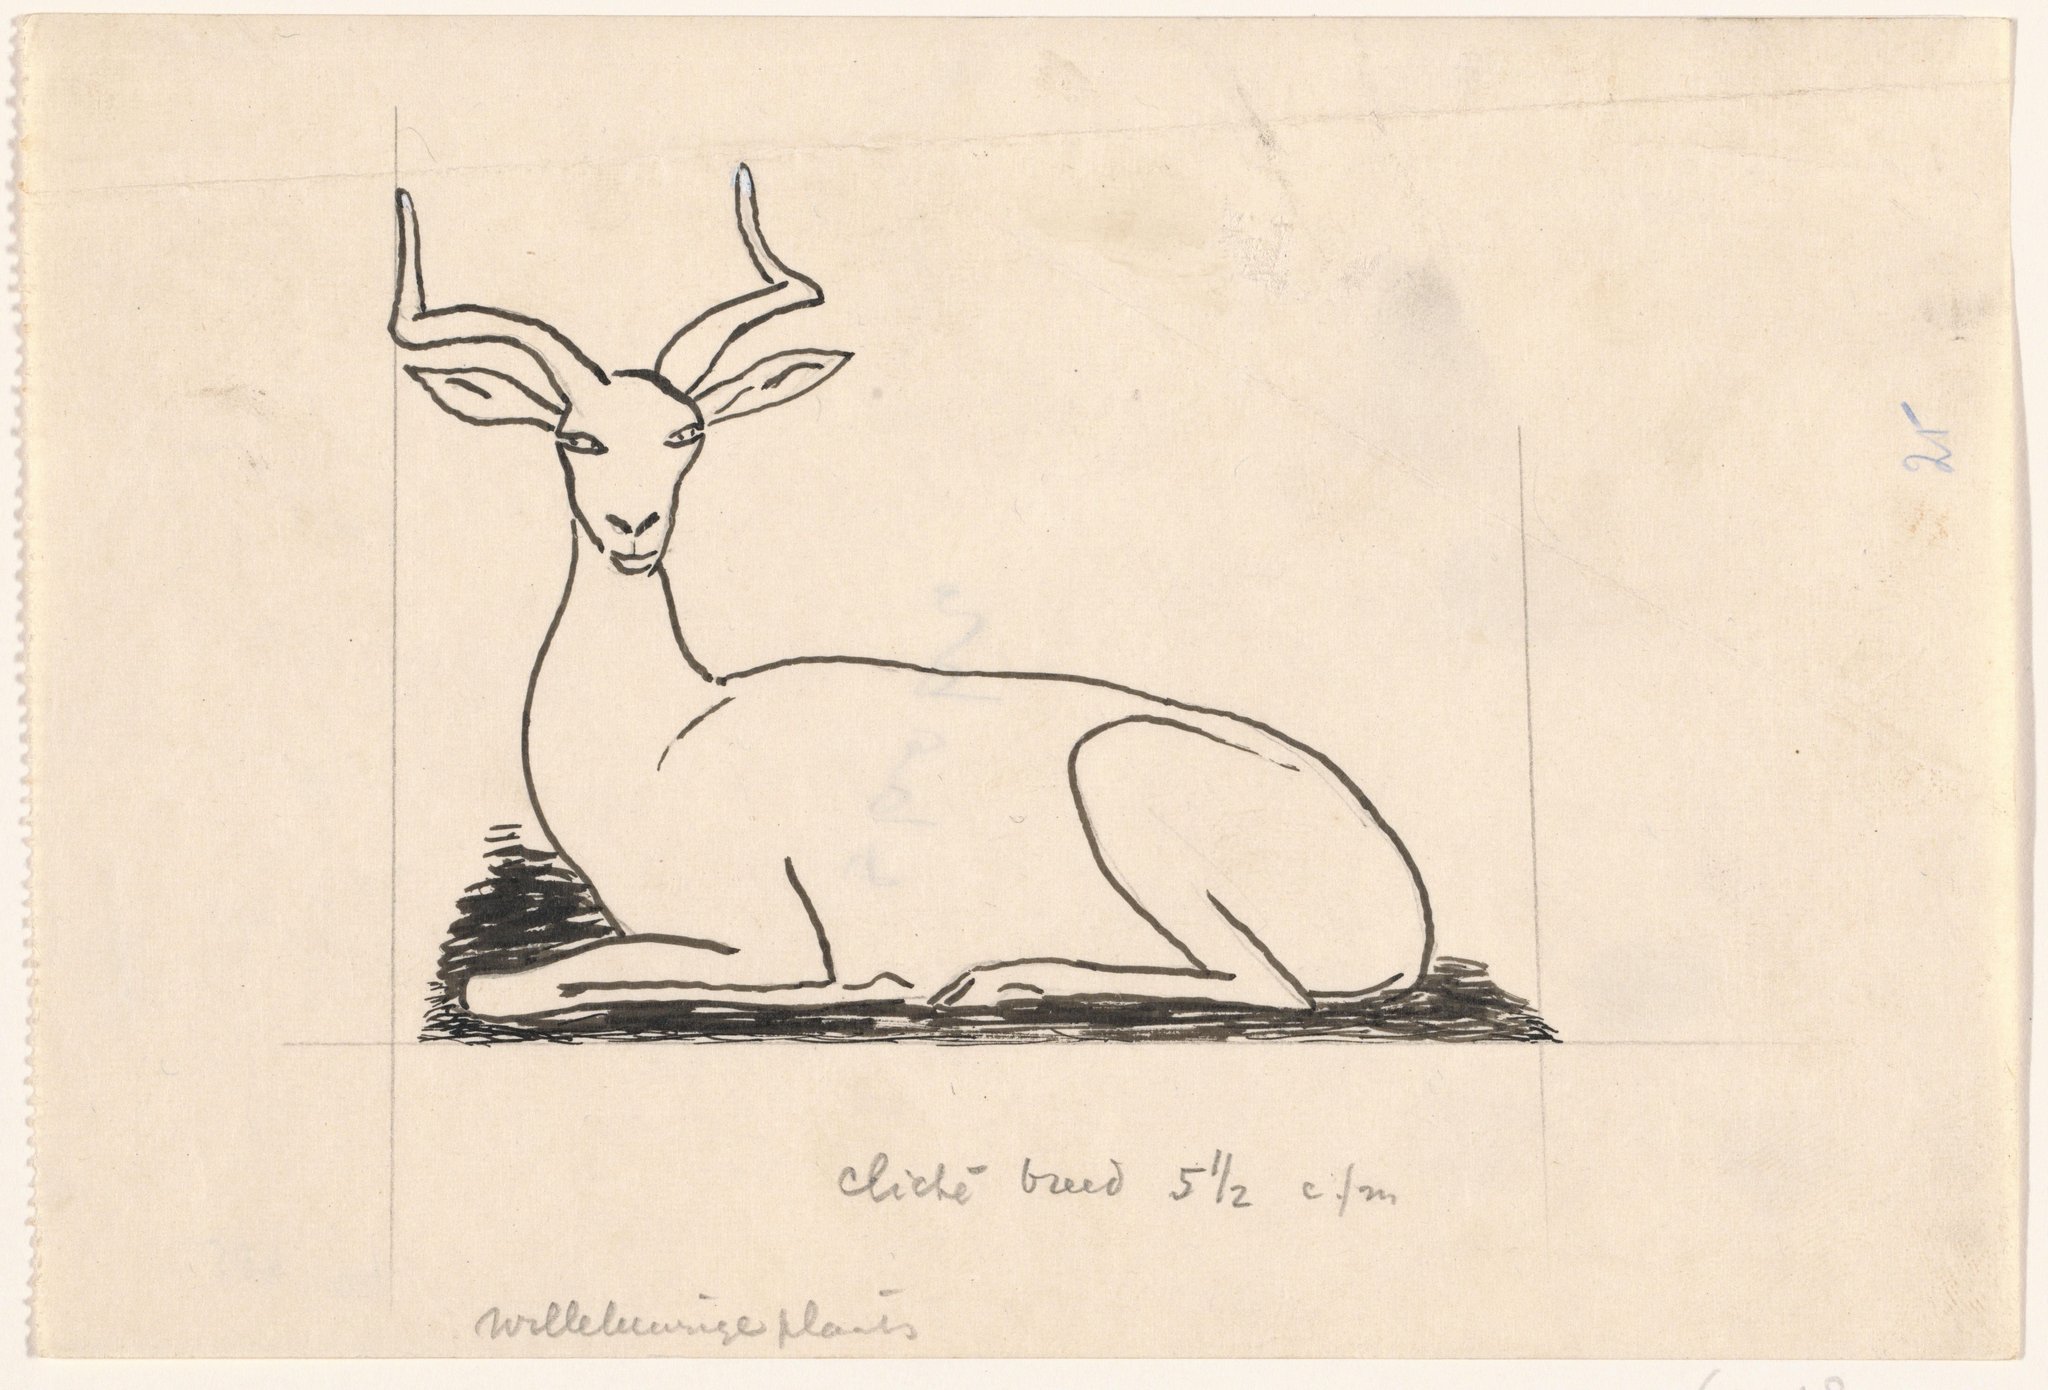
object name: boekillustratie ontwerp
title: Liggende bok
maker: leo gestel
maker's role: draughtsman, print maker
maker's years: 1881-1941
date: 1934-1936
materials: paper, pencil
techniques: brush, pen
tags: (cohen, van anarchist tot monarchist) specific works of literature (with author, title), he-goat, billy-goat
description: Ontwerp voor een boekillustratie voor: Cohen, Alexander. Van anarchist tot monarchist. Amsterdam: De Steenuil, 1936.